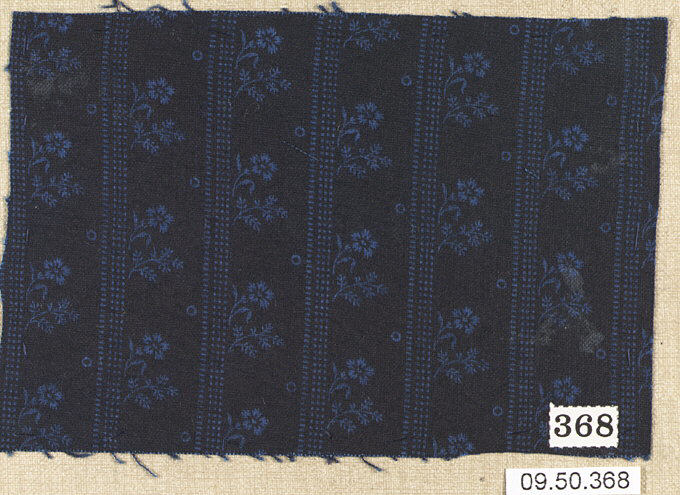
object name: piece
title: Piece (one of 116)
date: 1801-1900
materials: cotton